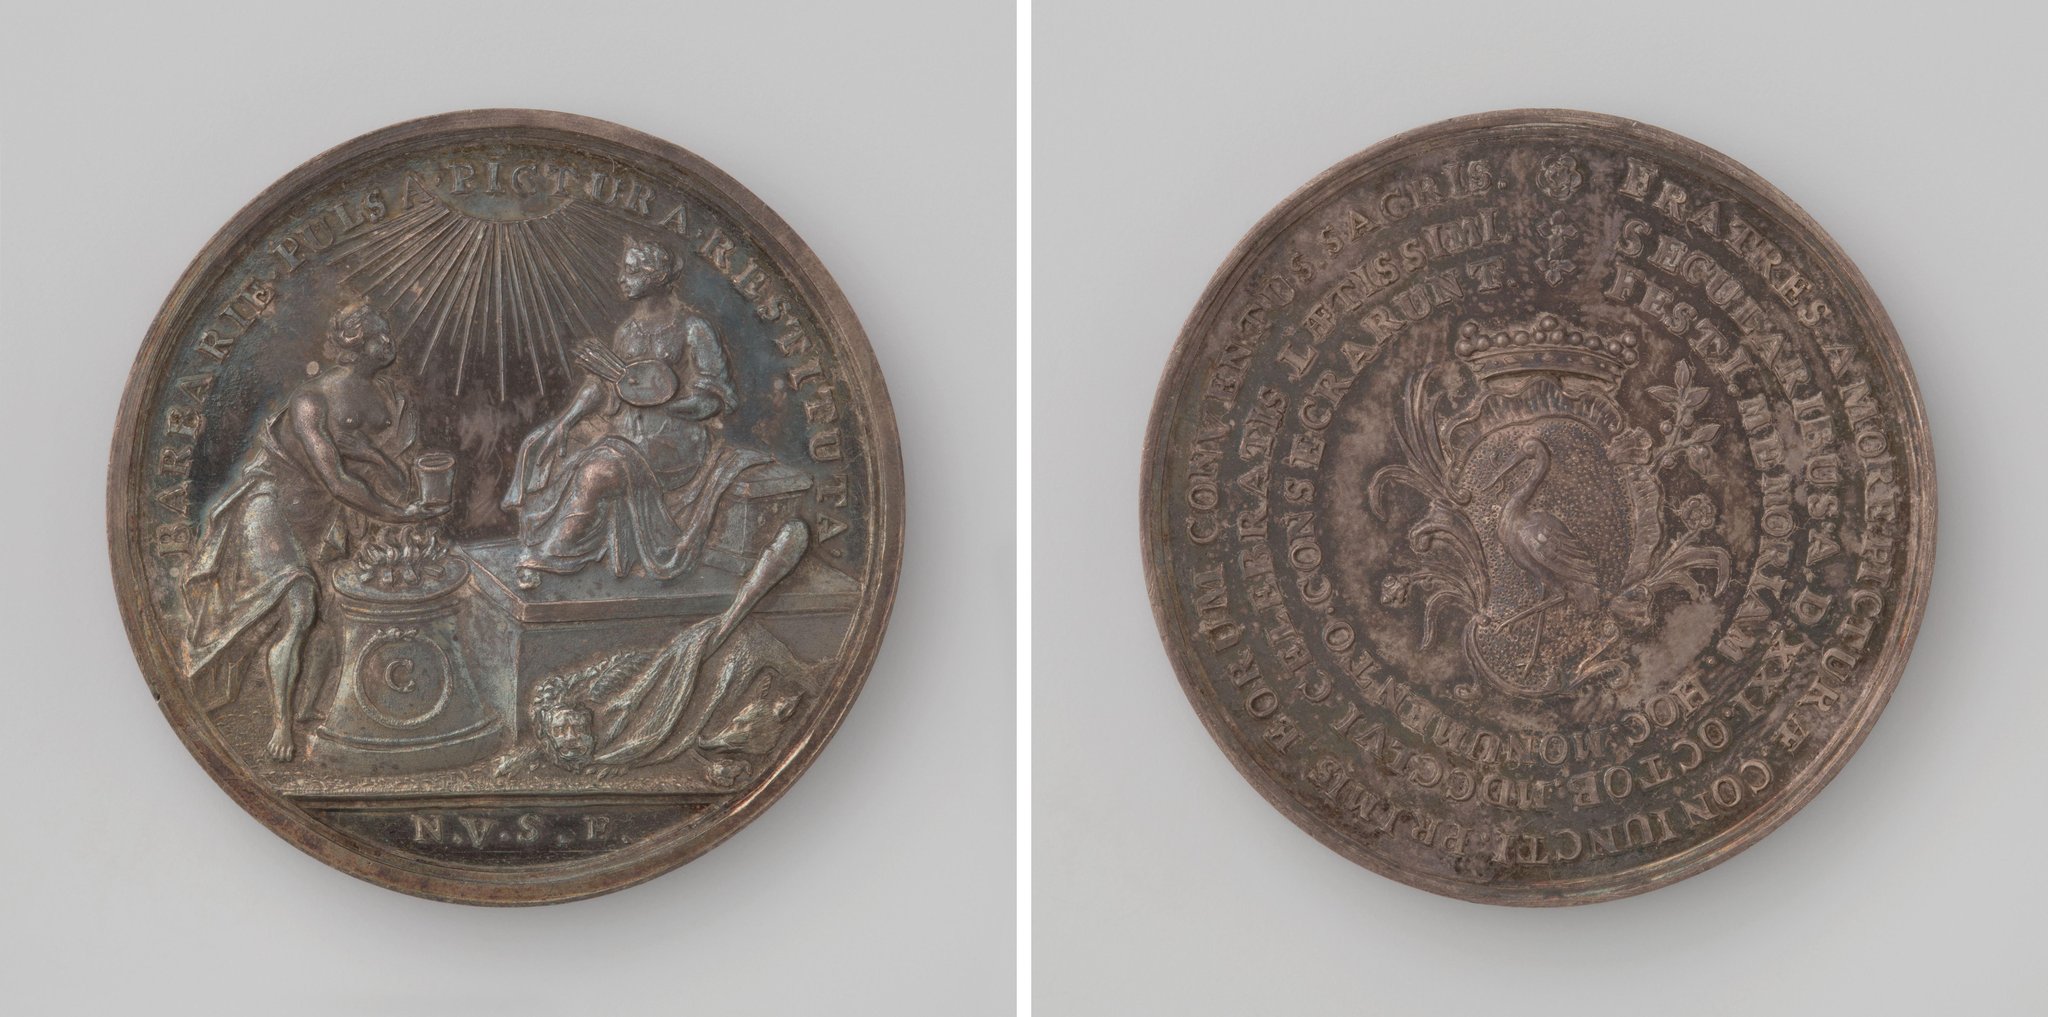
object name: history medal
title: Eerste eeuwfeest van de Confrerie Pictura, de tekenacademie te 's-Gravenhage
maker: nicolaas van swinderen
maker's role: jeweler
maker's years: 1705-1760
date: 1756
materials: silver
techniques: striking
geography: the hague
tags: the hague